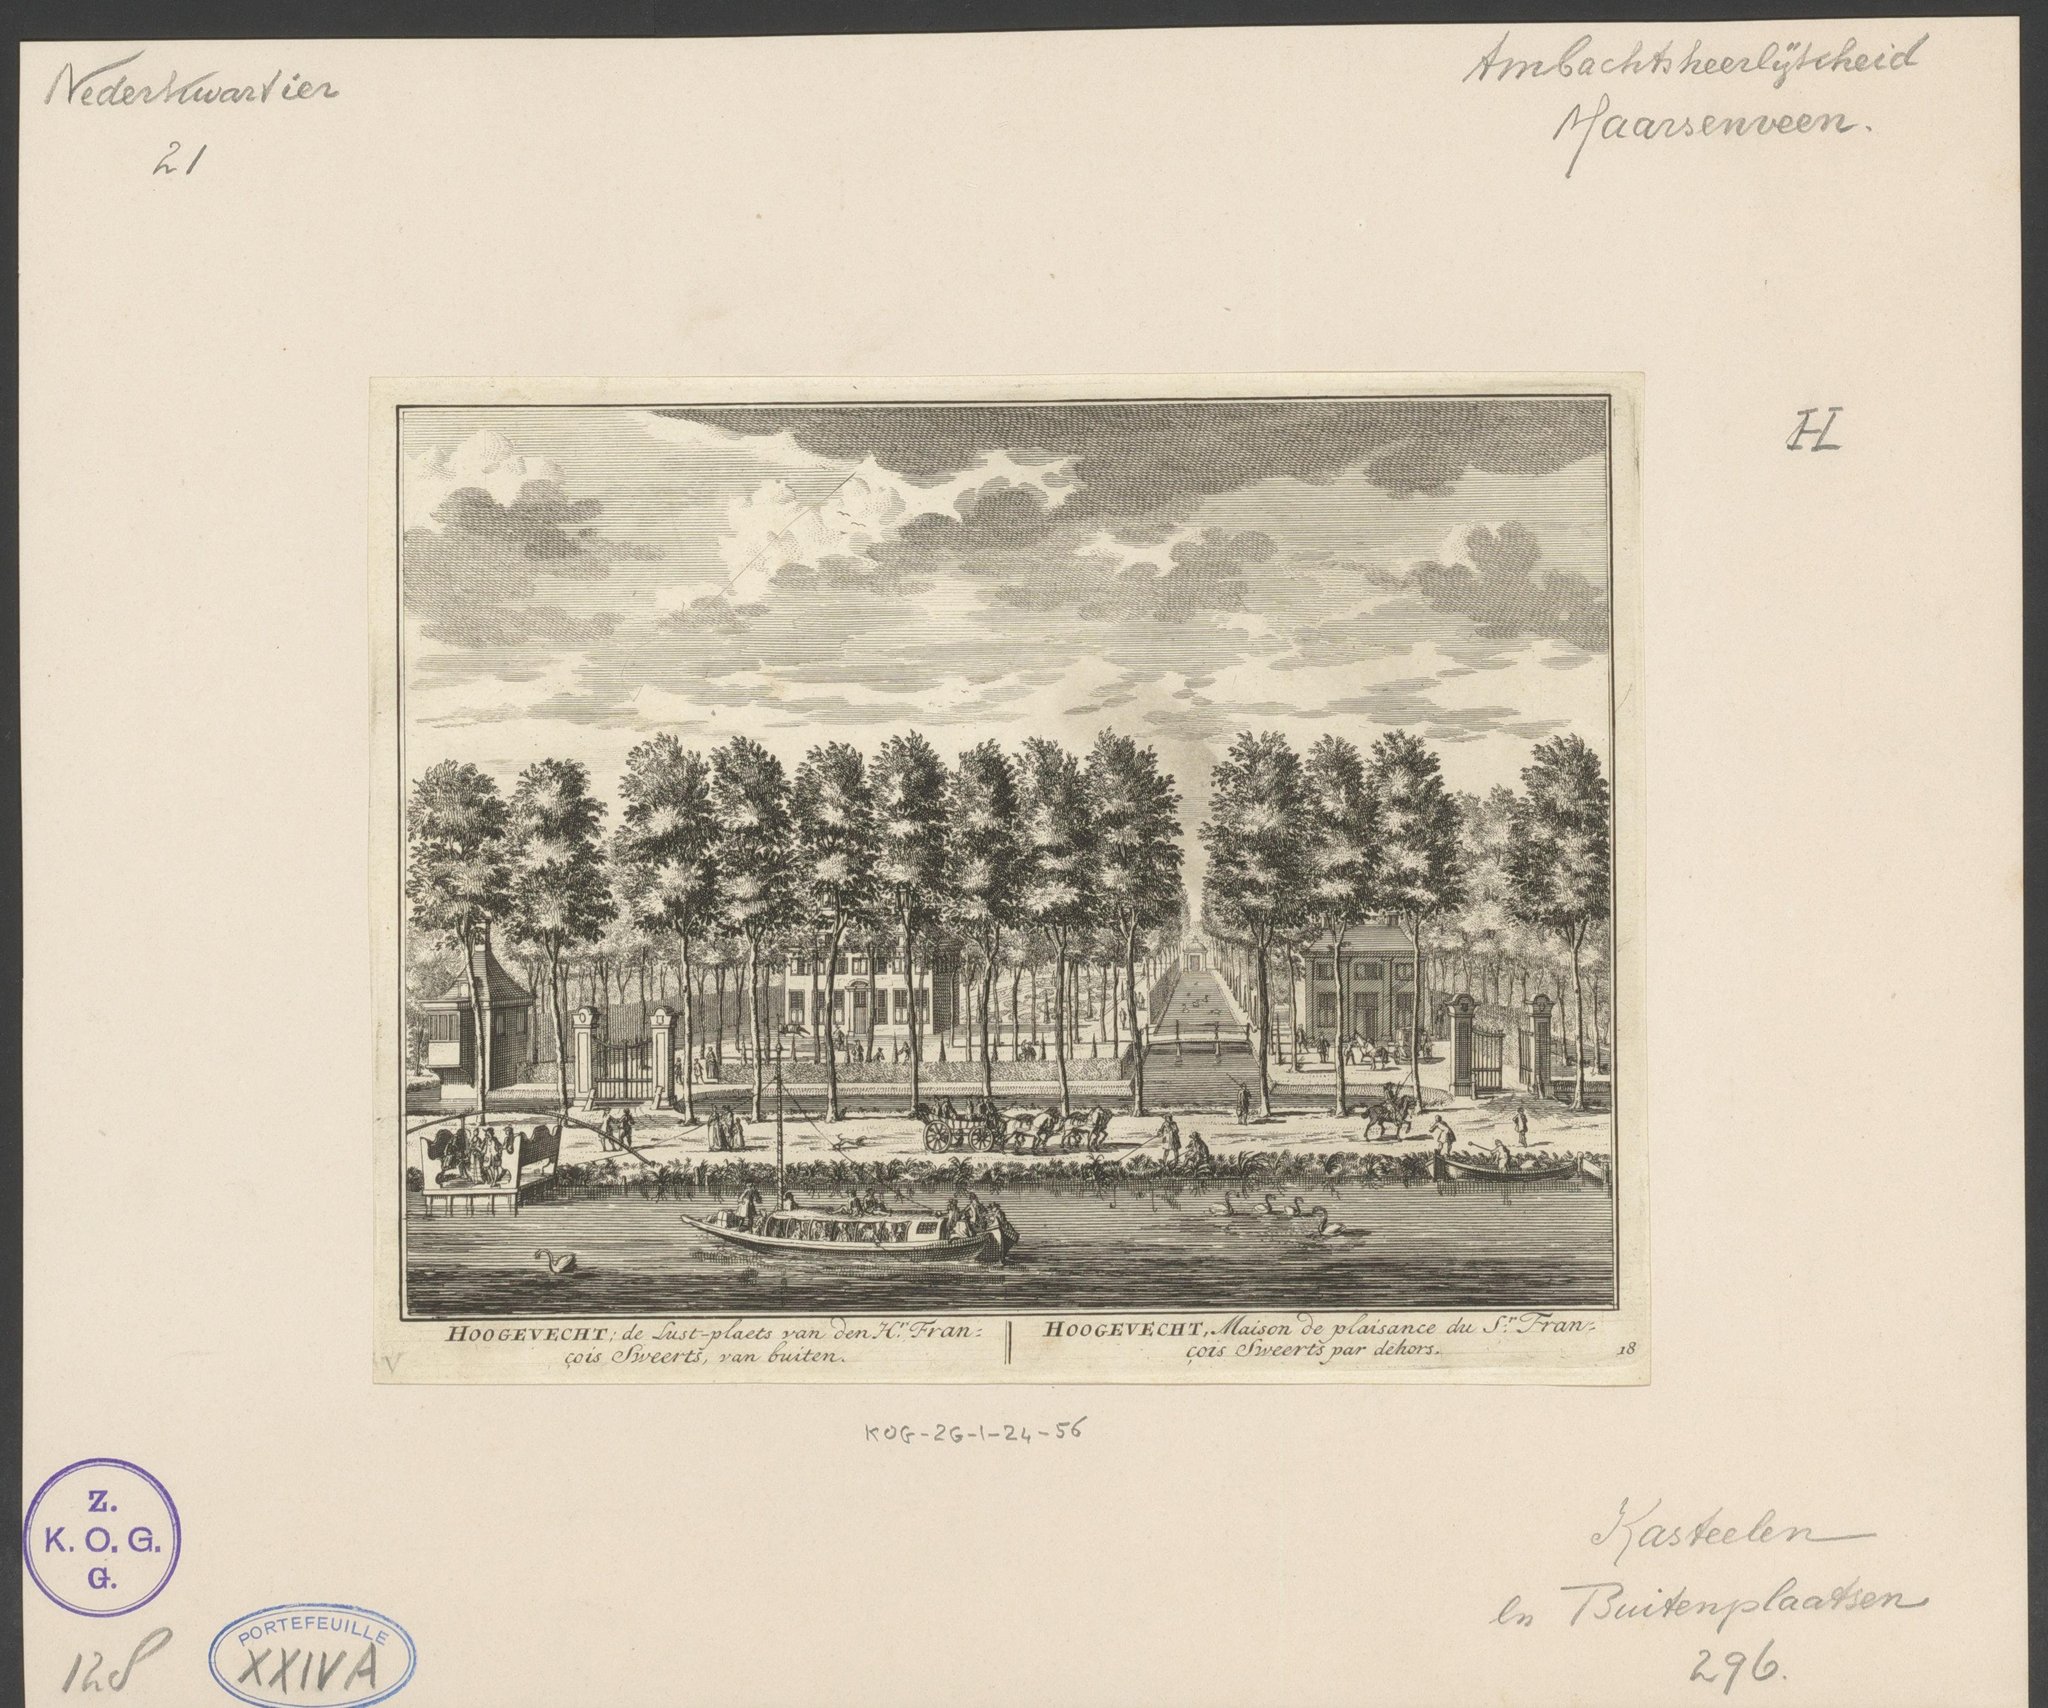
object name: print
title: Hoogevecht; de Lust-plaets van den Hr. Francois Sweerts, van buiten / Hoogevecht, Maison de plaisance du Sr. Francois Sweerts par dehors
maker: daniël stopendaal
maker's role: print maker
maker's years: 1672-1726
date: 1719-1790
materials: paper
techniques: engraving, etching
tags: river, rural housing, e.g. country-house, villa, cottage, maarssen, vecht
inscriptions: stamp, collector's mark: Lugt 1641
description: Prent mogelijk uit: Leth, Andries de. De zegepraalende Vecht, vertoonende verscheidene gesichten van lustplaatsen, heeren huysen en dorpen, beginnende van Uitrecht en met Muyden besluytende (...). Amsterdam: Weduwe Nicolaus Visscher, 1719. Of uit: Brouërius van Nidek, Matthaeus. De Vechtstroom, van Utrecht tot Muiden (...). Amsterdam: H. Gartman, W. Vermandel en J.W. Smit, 1790.